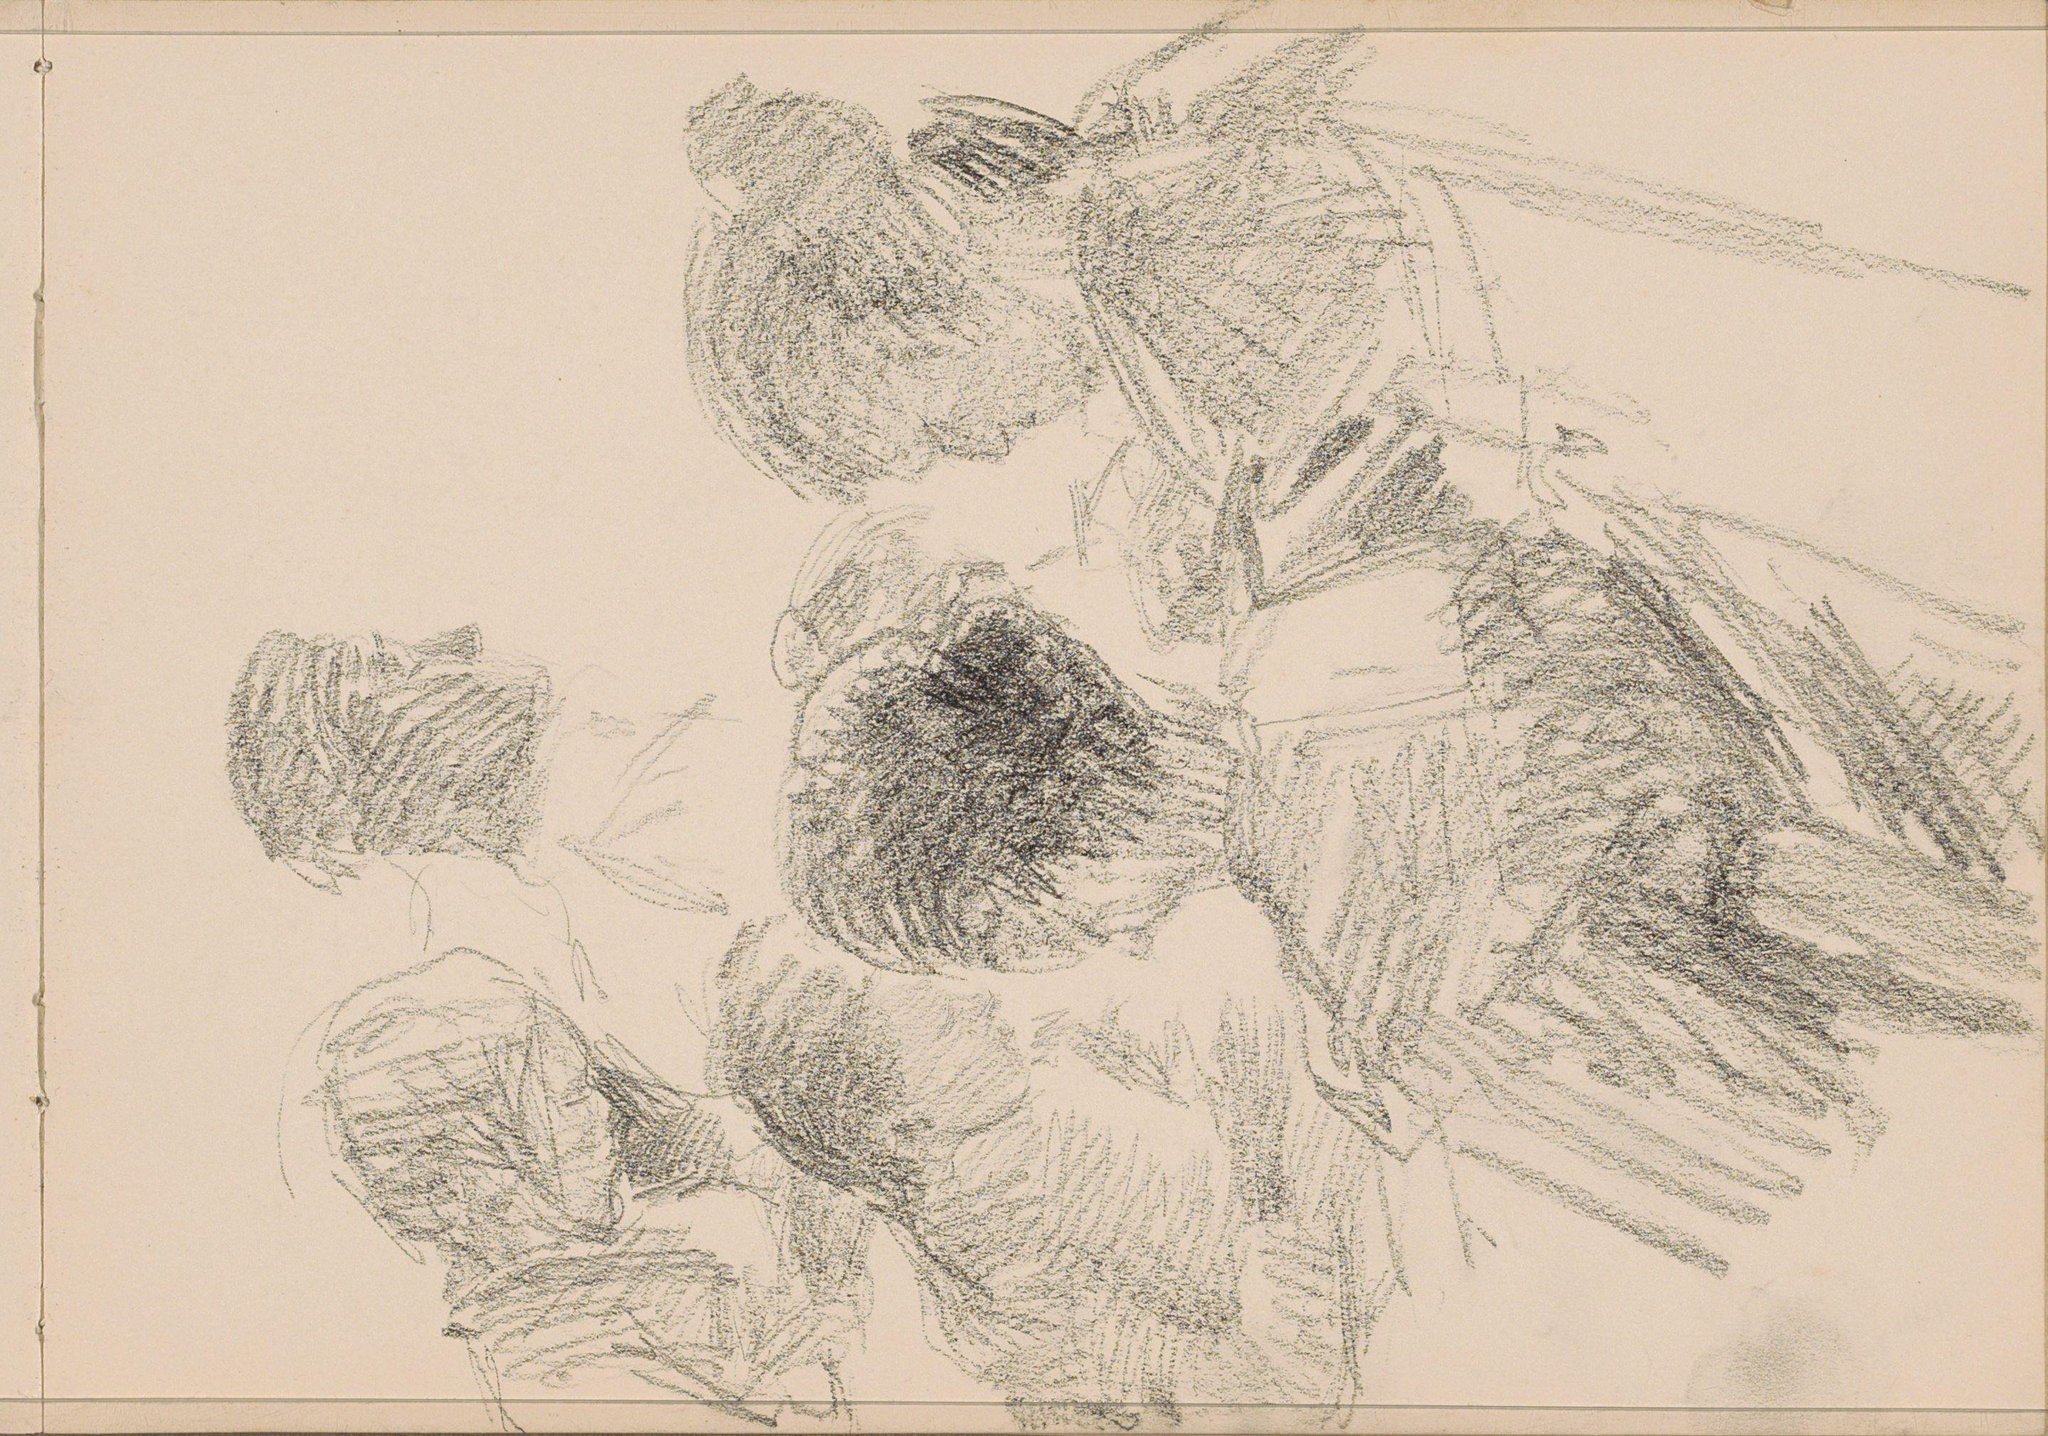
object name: sketchbook leaf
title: Vier vrouwen aan een tafel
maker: a.a.l. de grammont-hubrecht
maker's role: draughtsman, painter, print maker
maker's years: 1855-1913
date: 1865-1913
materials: chalk, paper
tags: sitting figure, adult woman, table, home sewing; repair of clothes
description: Enkele van de vrouwen zijn aan het handwerken. Blad 51 recto uit een schetsboek met 68 bladen.